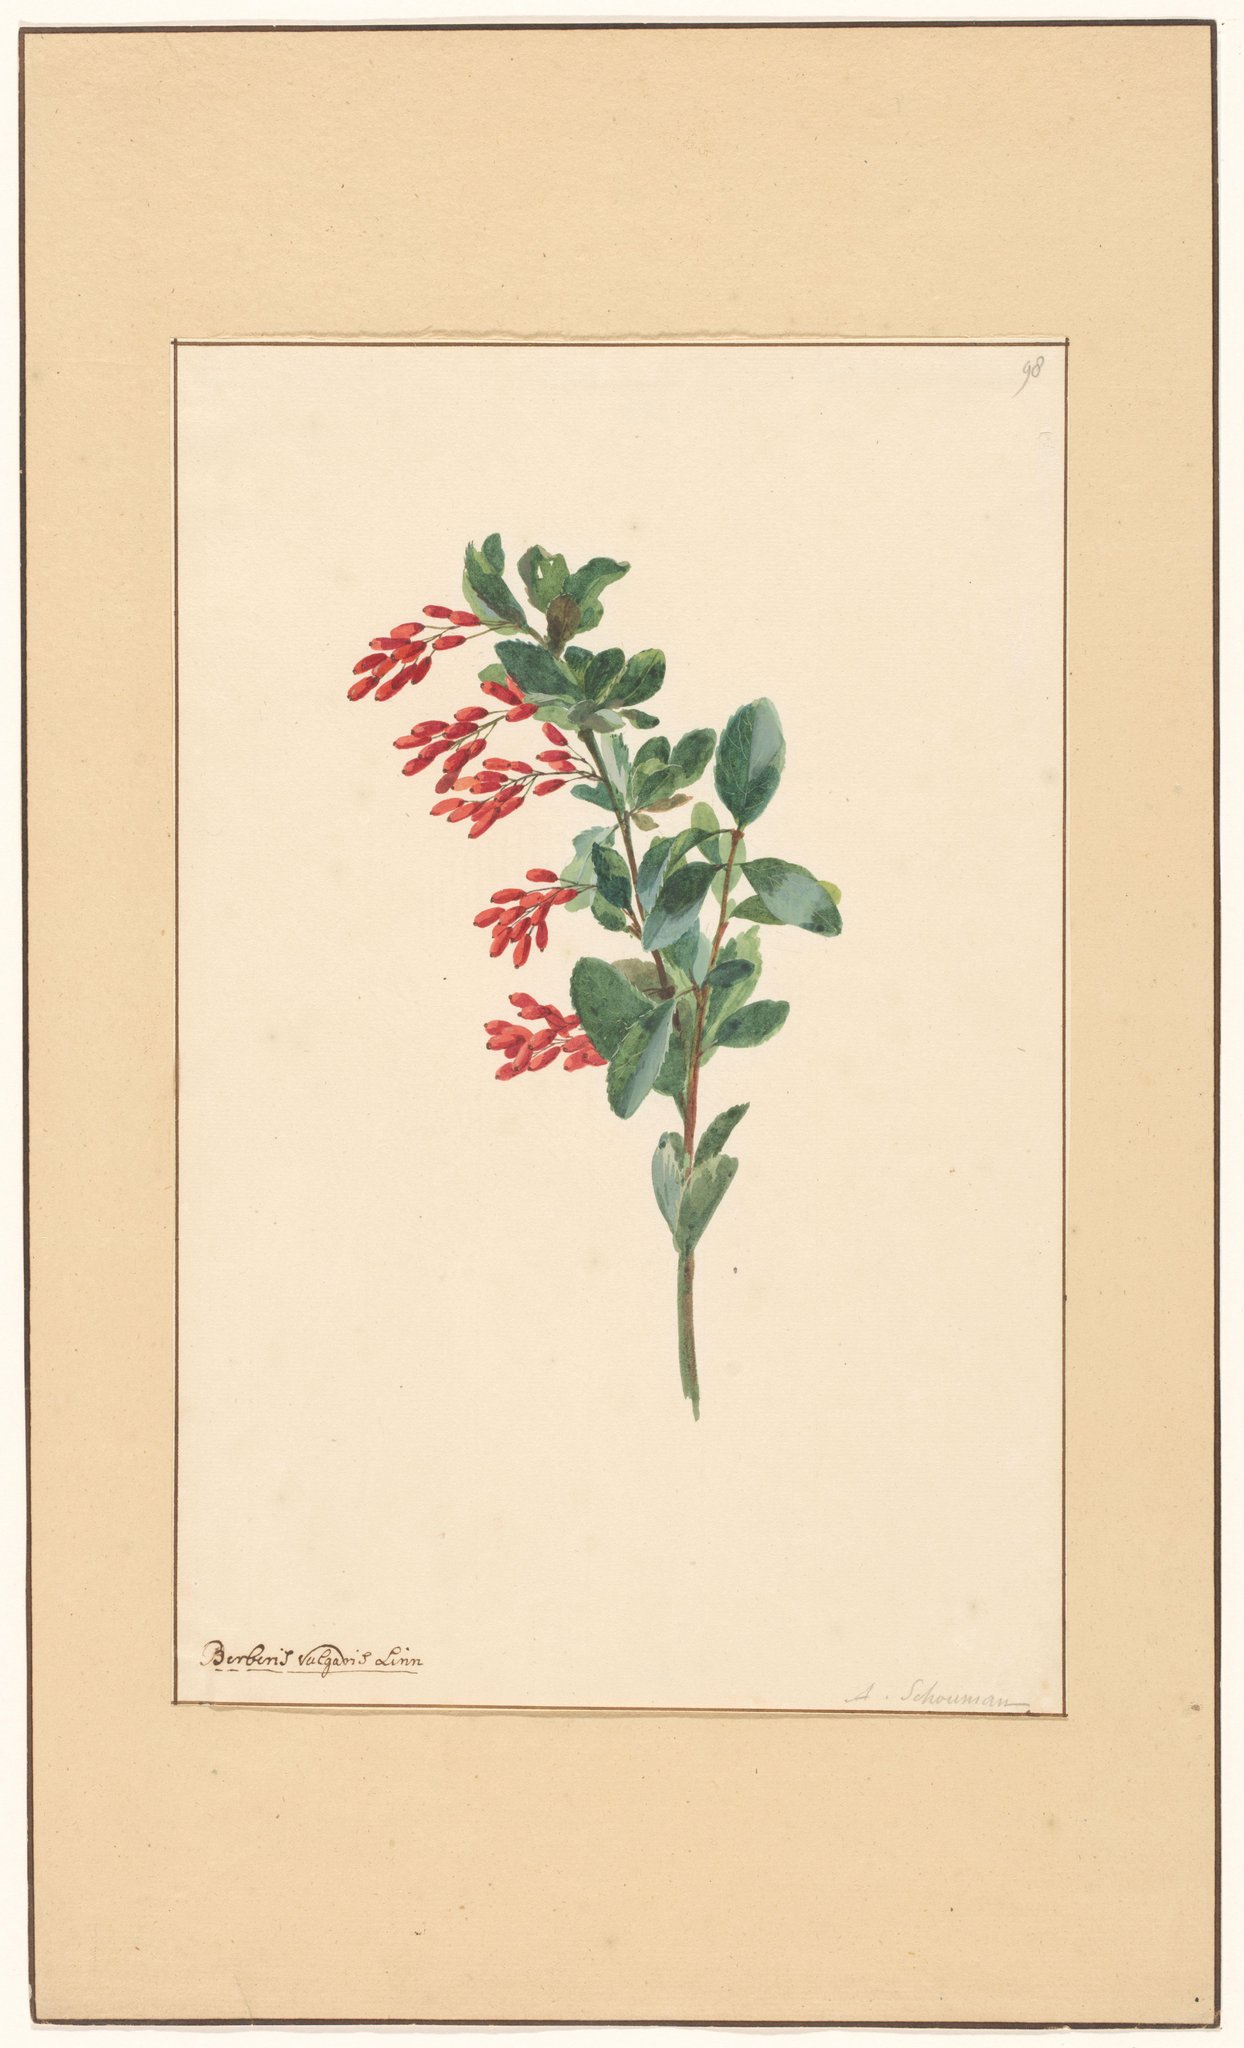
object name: drawing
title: Tak van een zuurbes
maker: willem van leen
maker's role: draughtsman, print maker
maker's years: 1753-1825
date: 1775-1825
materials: gouache, pencil, watercolor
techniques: brush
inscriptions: annotation: ‘A. Schouman’, inscription: ‘98’, annotation: ‘Berberis vulgaris Linn’